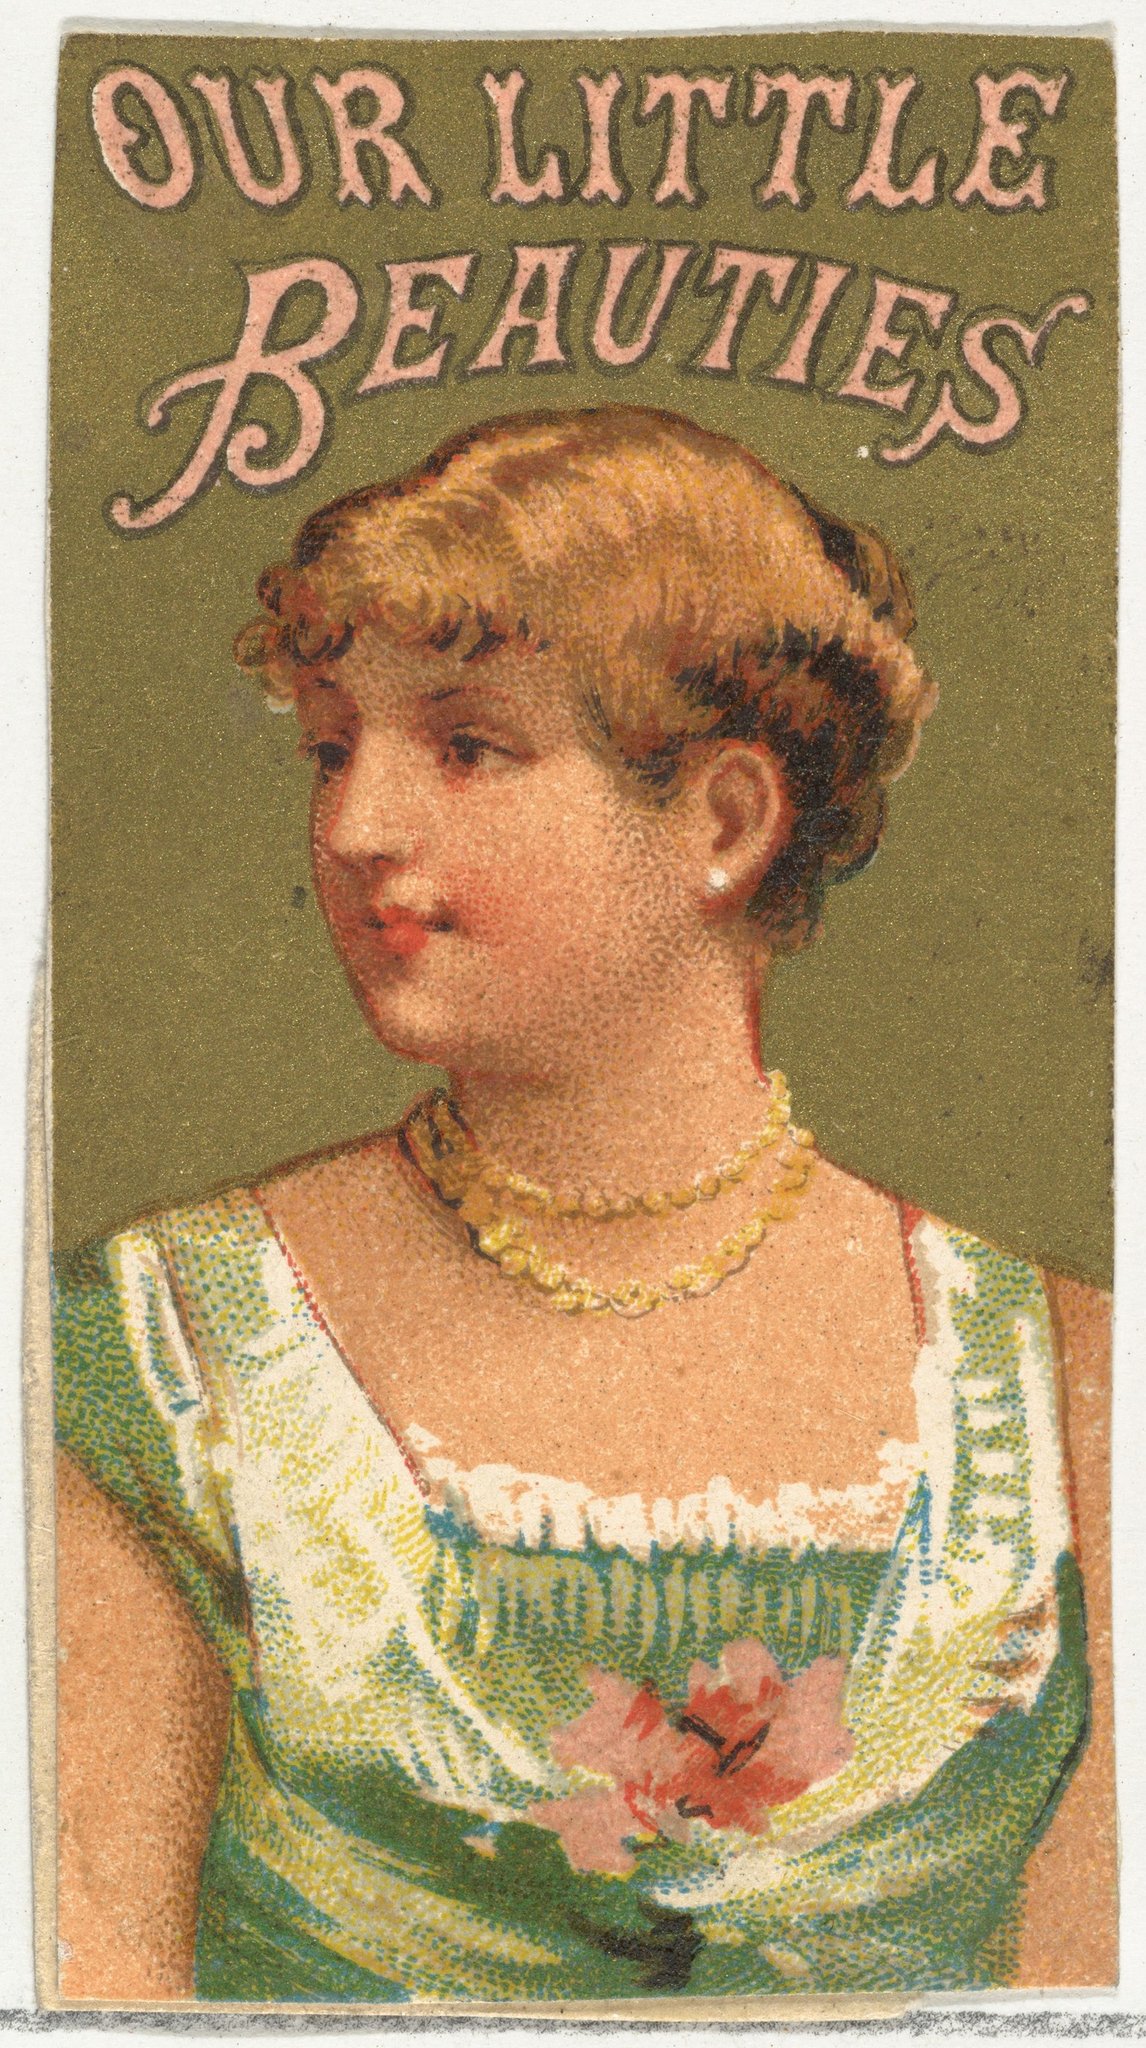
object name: print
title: From the Girls and Children series (N58) promoting Our Little Beauties Cigarettes for Allen & Ginter brand tobacco products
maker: allen & ginter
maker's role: publisher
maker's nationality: american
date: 1887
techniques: color lithograph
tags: girls,portraits